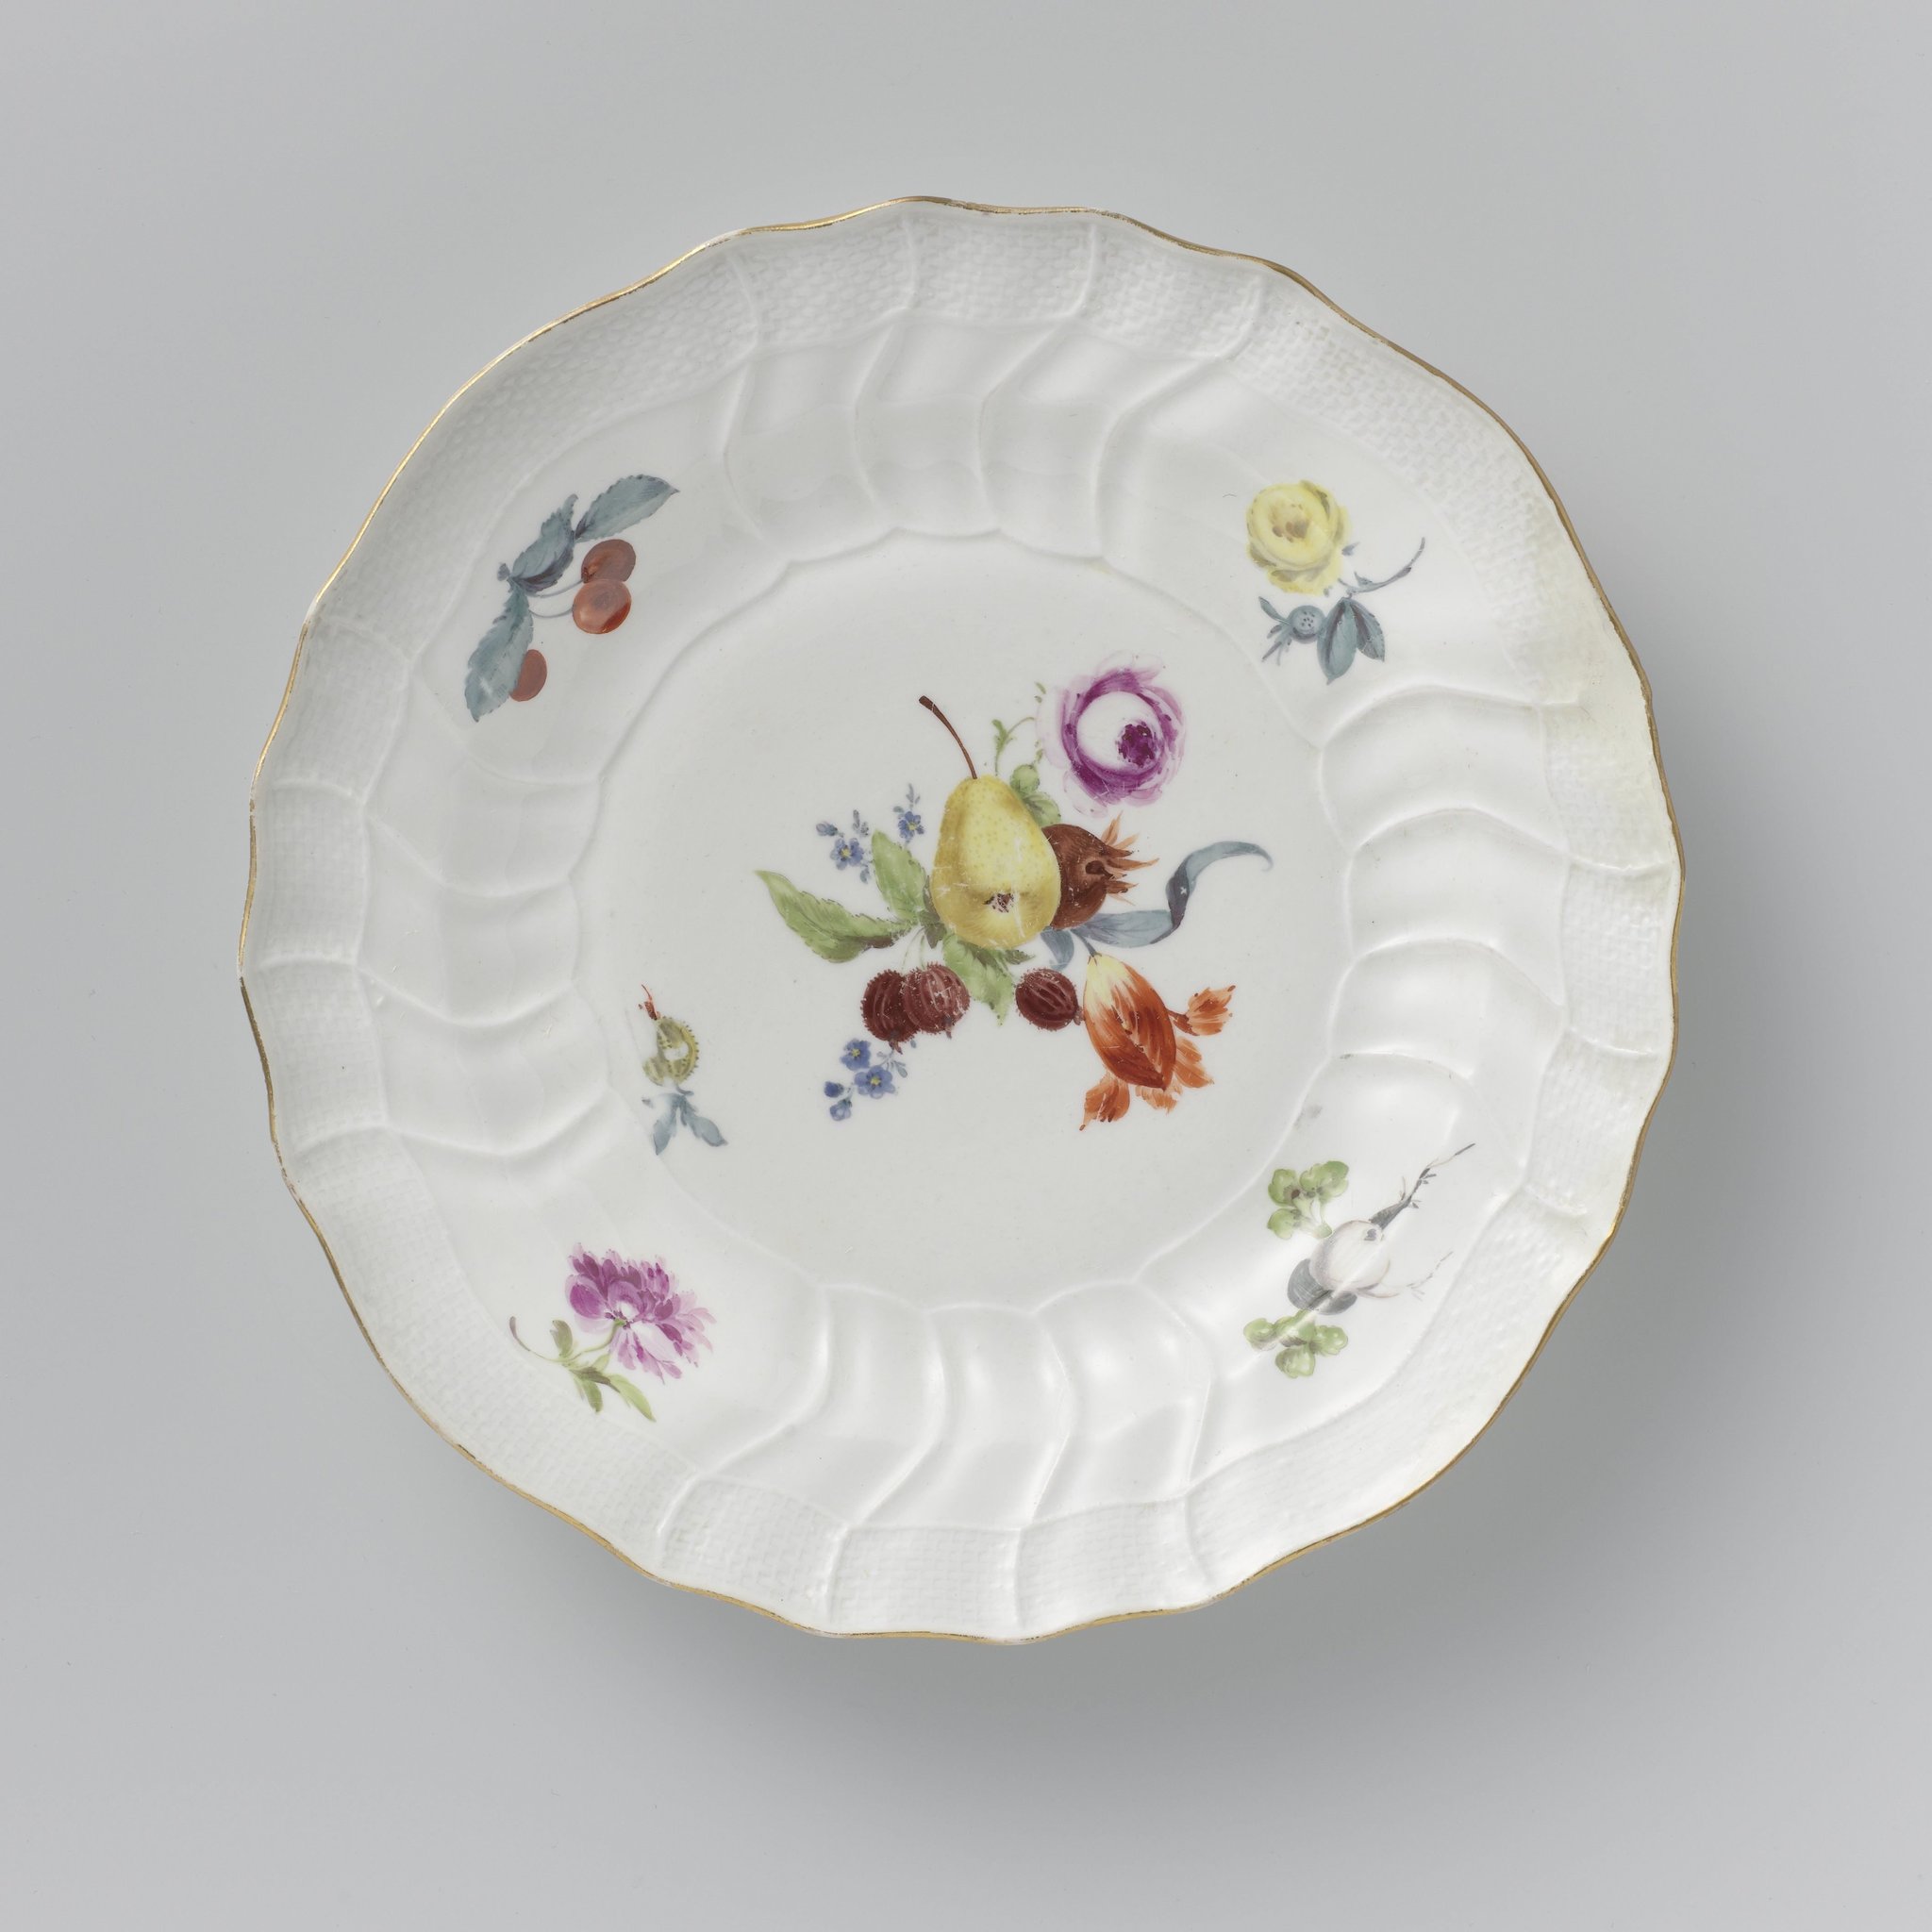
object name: eating drinking utensil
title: Bord, veelkleurig beschilderd met Deutsche Blumen, insekten en vruchten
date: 1750-1760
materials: porcelain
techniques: painted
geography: meissen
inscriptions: factory mark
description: Rond bord van beschilderd porselein. De rand is versierd met het Neuozier-patroon in reliëf. De beschildering bestaat uit Deutsche Blumen, insekten en vruchten. Het bord is gemerkt en hoort bij een servies (BK-17474-1 t/m BK-17474-253).